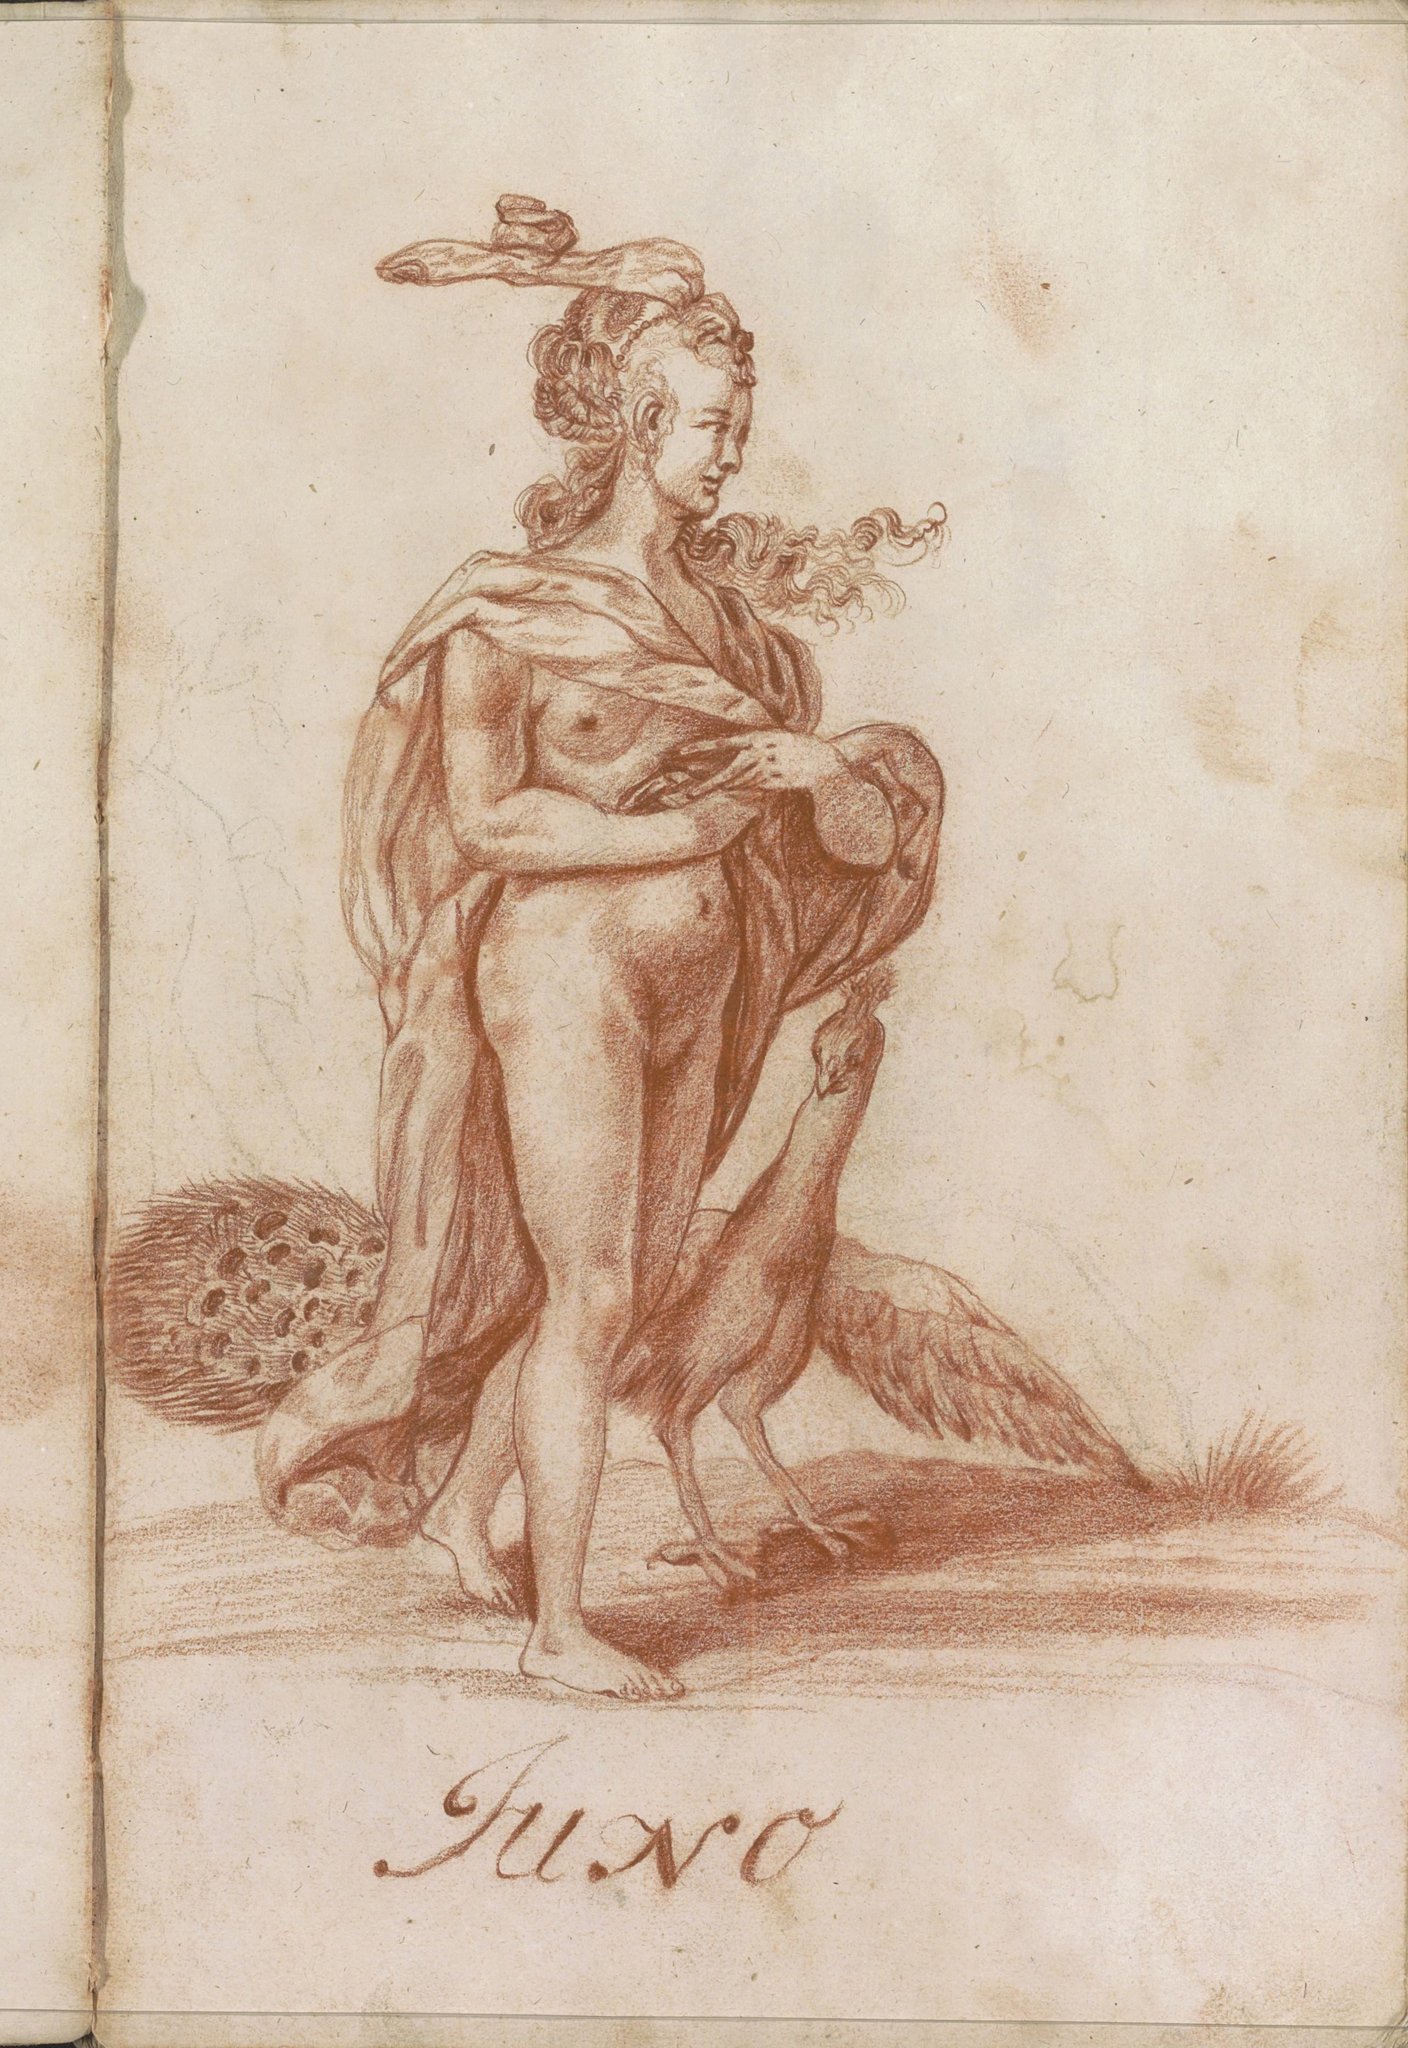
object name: sketchbook leaf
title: Juno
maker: hendrick van beaumont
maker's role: draughtsman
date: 1696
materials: chalk, paper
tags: (story of) juno (hera)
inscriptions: annotation: ‘JUNO’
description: Juno draagt een mantel over haar naakte lichaam. Naast haar een pauw. Blad 7 recto uit een schetsboek met 91 bladen.